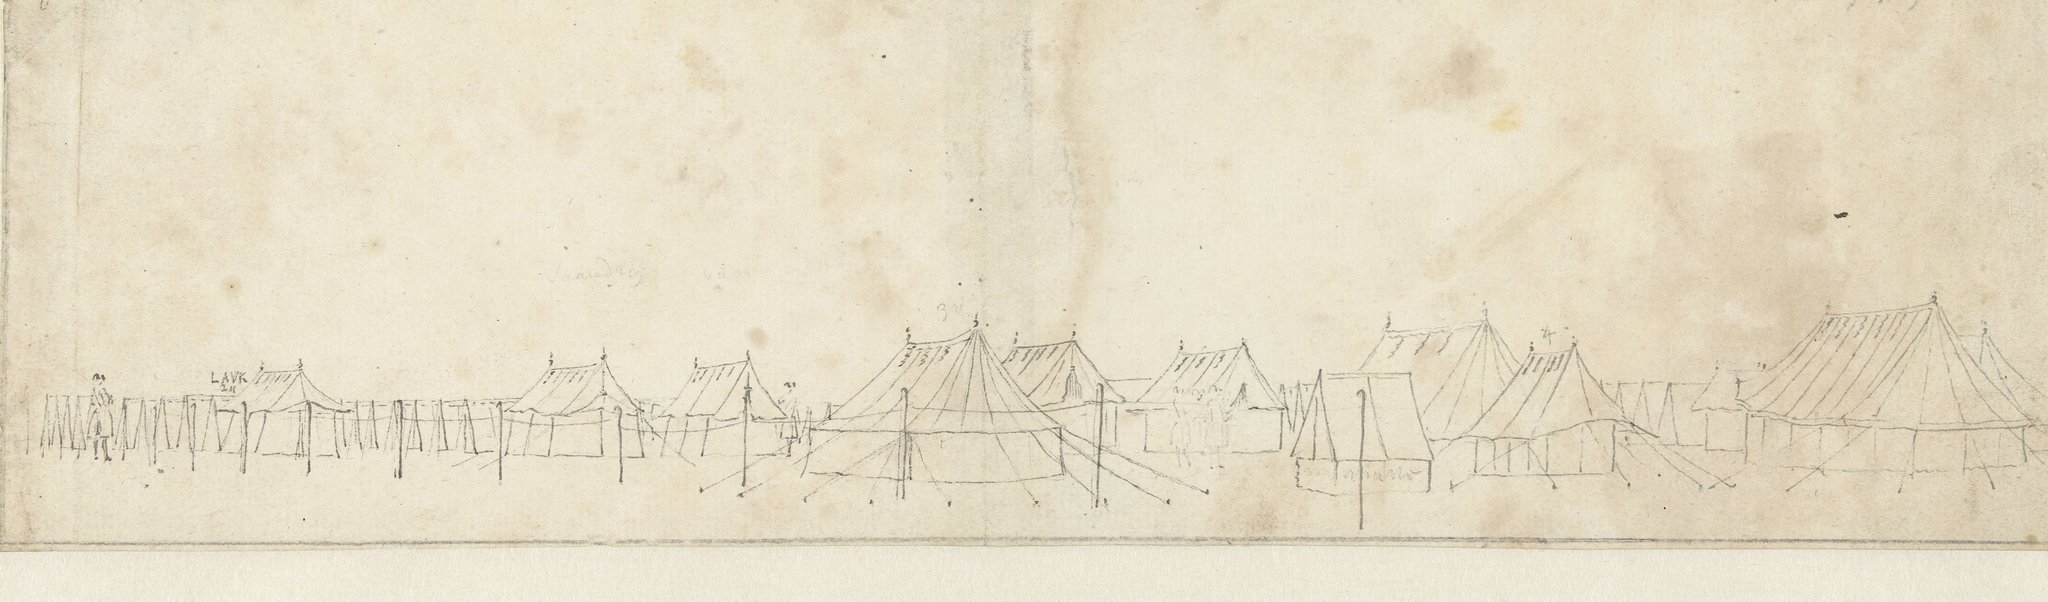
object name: drawing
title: Het cavaleriekamp op het Malieveld te 's-Gravenhage, 1742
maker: cornelis pronk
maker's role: draughtsman, painter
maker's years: 1691-1759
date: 1742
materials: ink, paper, pencil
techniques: pen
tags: (military) camp with tents, historical events and situations, the hague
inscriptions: inscription: ‘[...?] vaandrig [..?] zijn [....?]’, inscription: ‘gezien uyt de tent van Brunel’